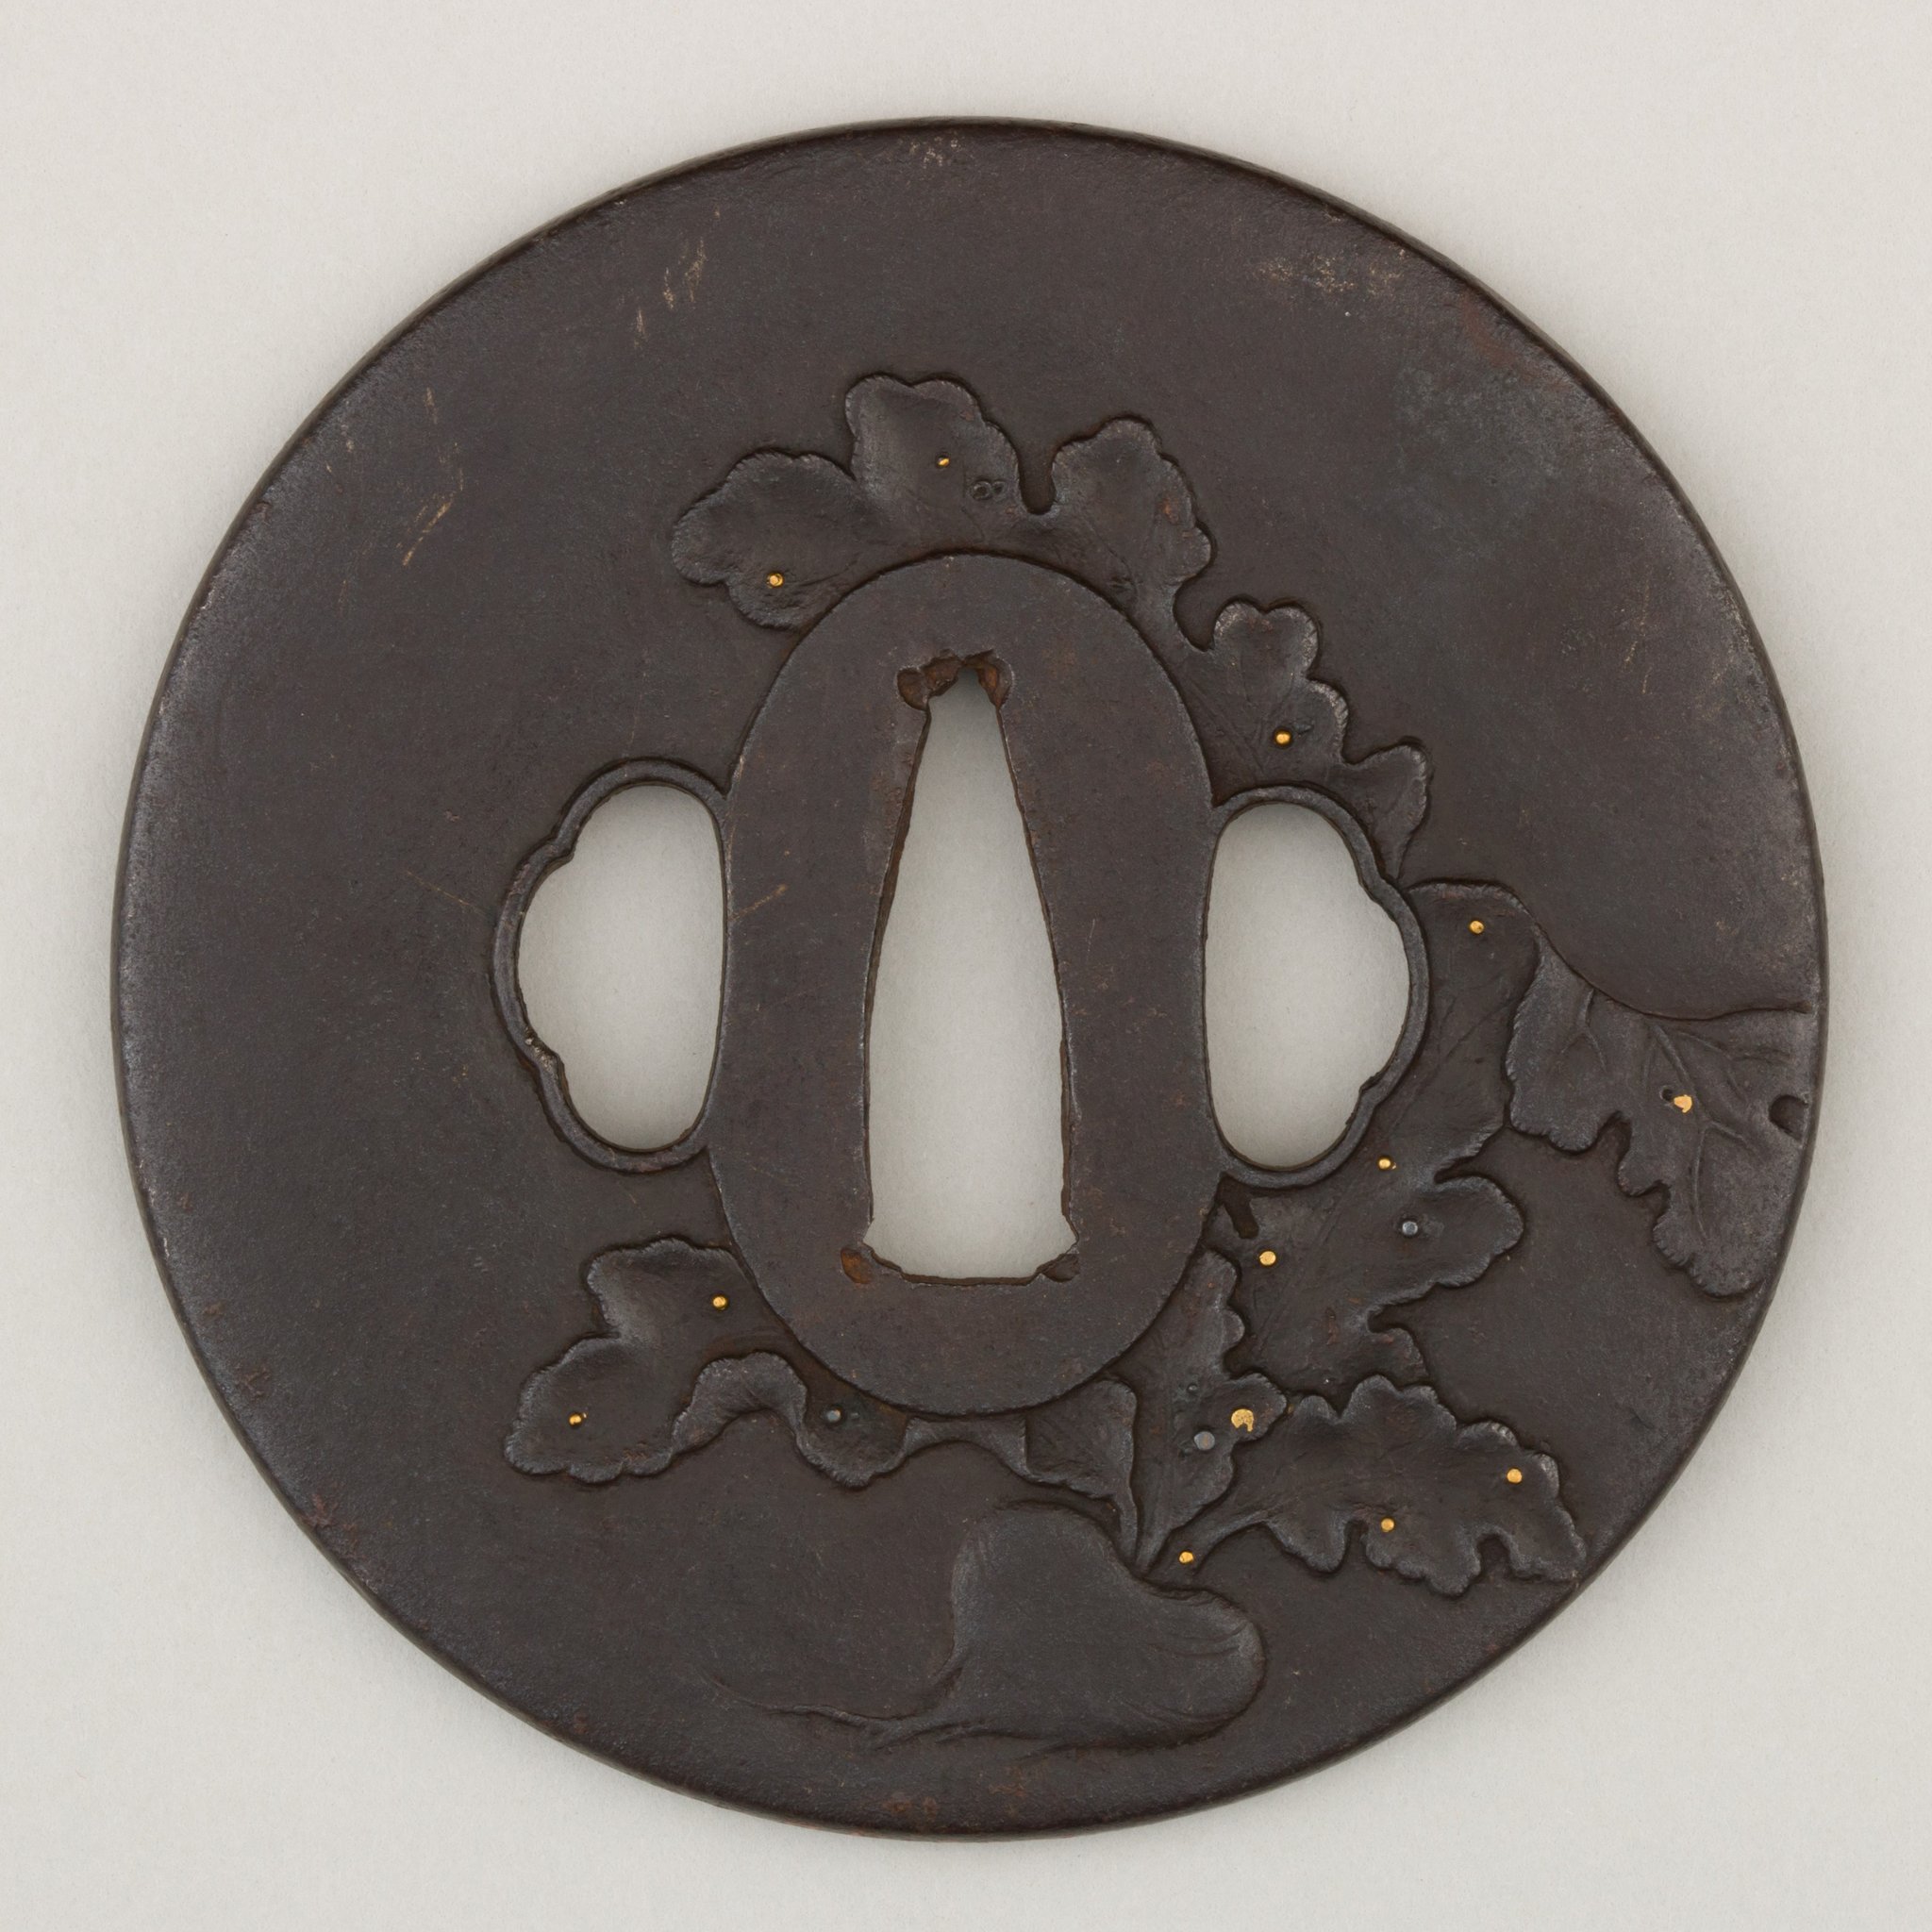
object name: sword guard tsuba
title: Sword Guard (Tsuba)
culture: japanese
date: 1601-1633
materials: copper, gold, iron, silver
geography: japan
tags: vegetables